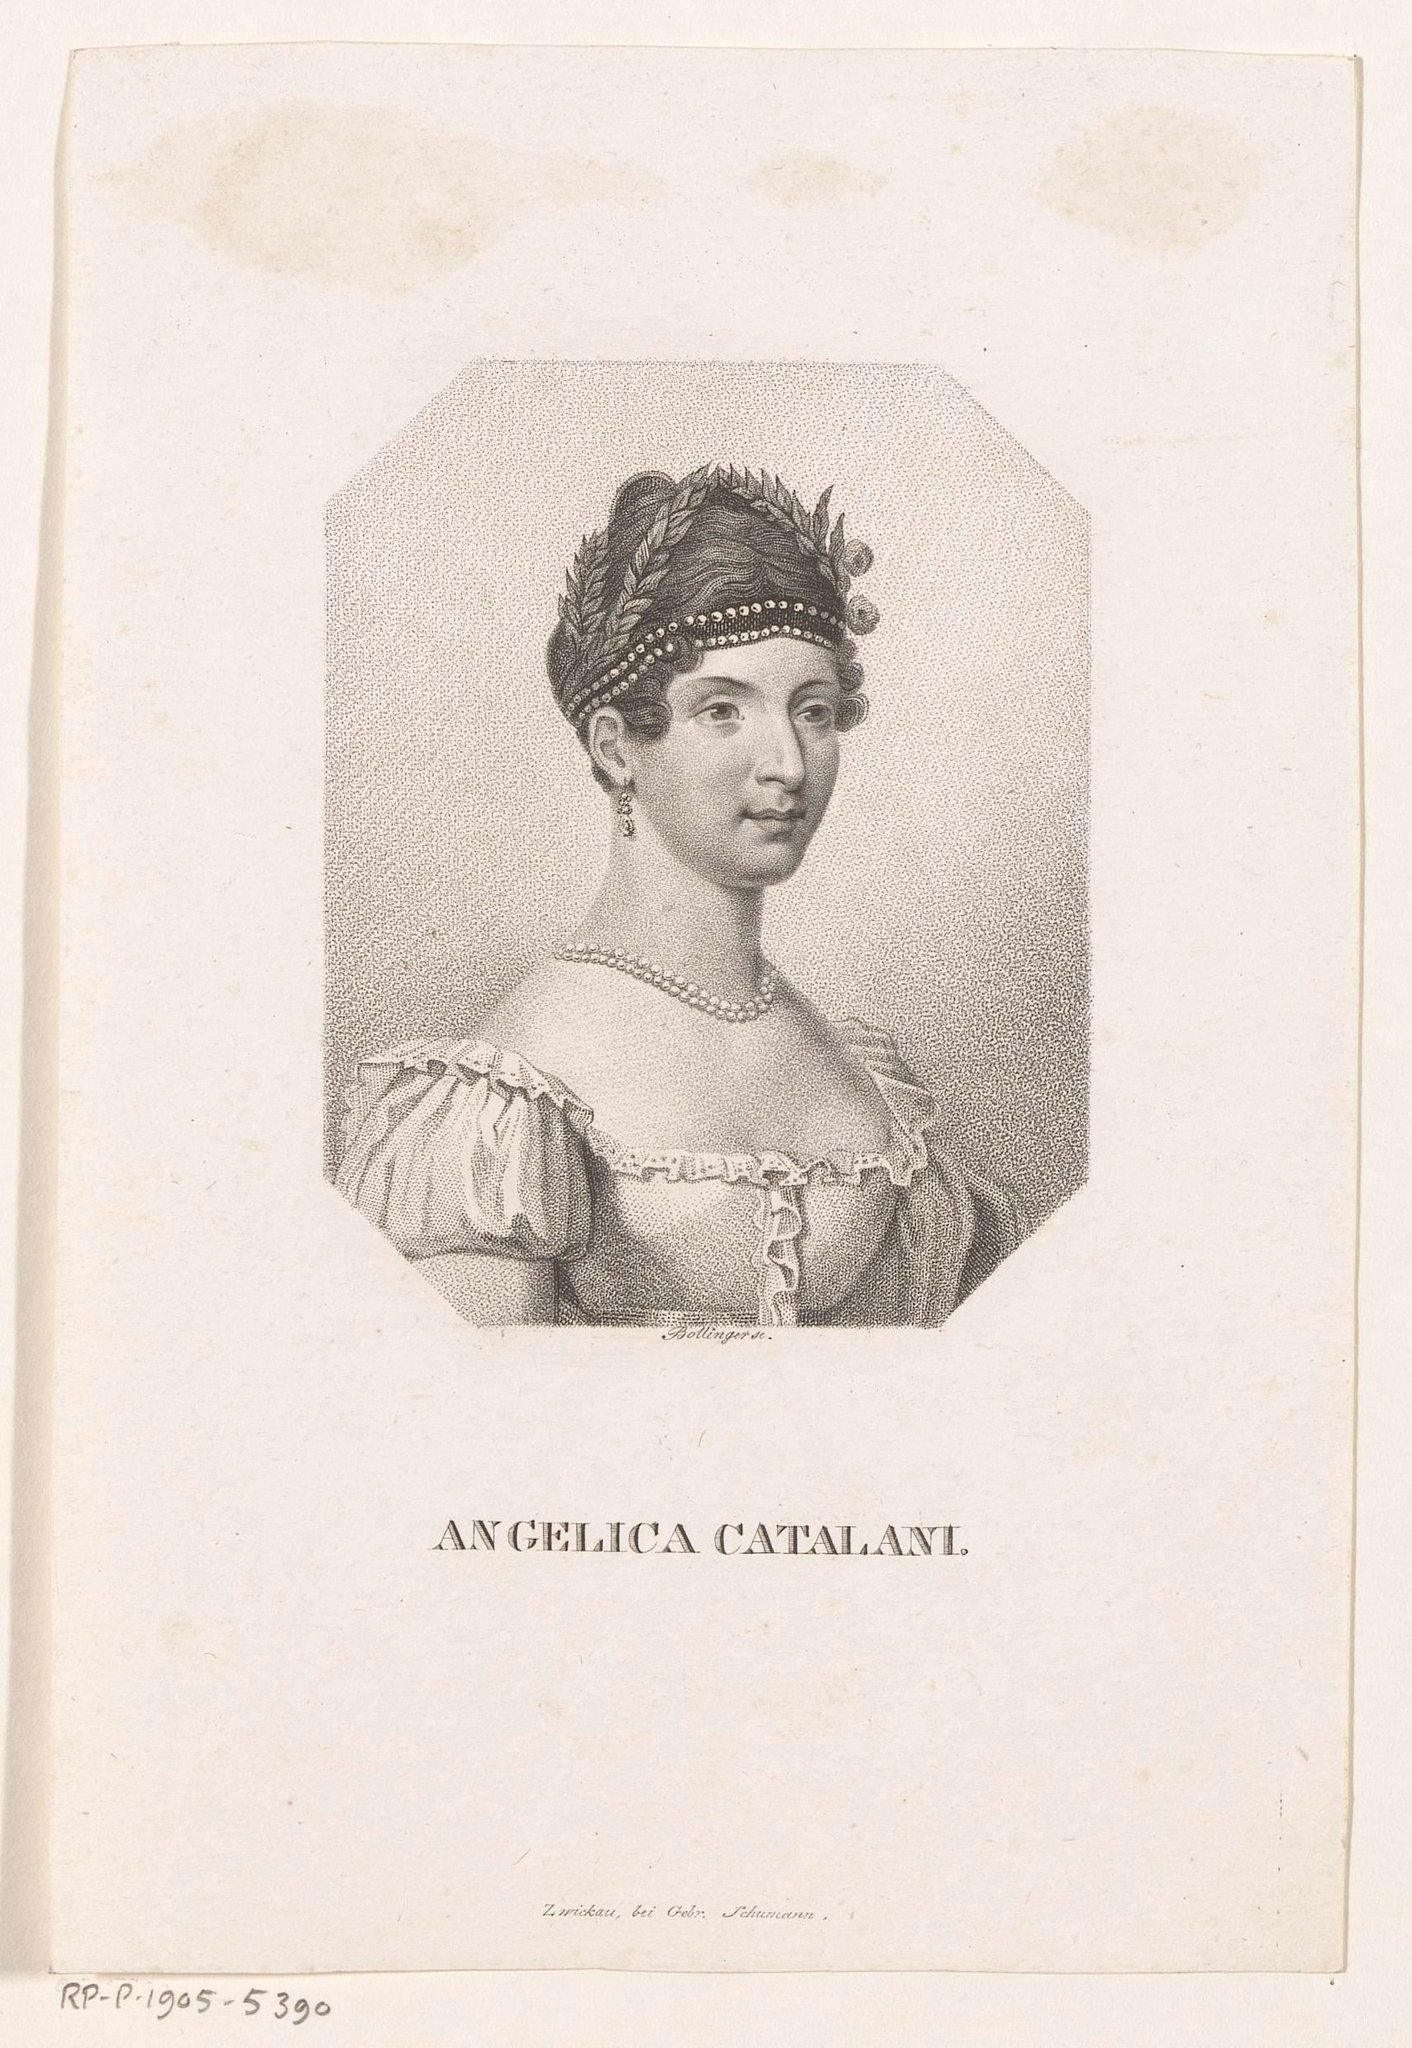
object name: print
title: Bildnisse der berühmtesten Menschen aller Völker und Zeiten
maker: friedrich wilhelm bollinger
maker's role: print maker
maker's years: 1777-1825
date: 1818-1832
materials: paper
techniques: stippling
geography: zwickau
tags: paris, historical persons - bb - woman, portrait of opera-singer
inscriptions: collector's mark: Lugt 2228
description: Prent gebruikt door de serie 'Bildnisse der berühmtesten Menschen aller Völker und Zeiten' van de gebroeders Schumann, uitgegeven in 1818-1832 te Zwickau.